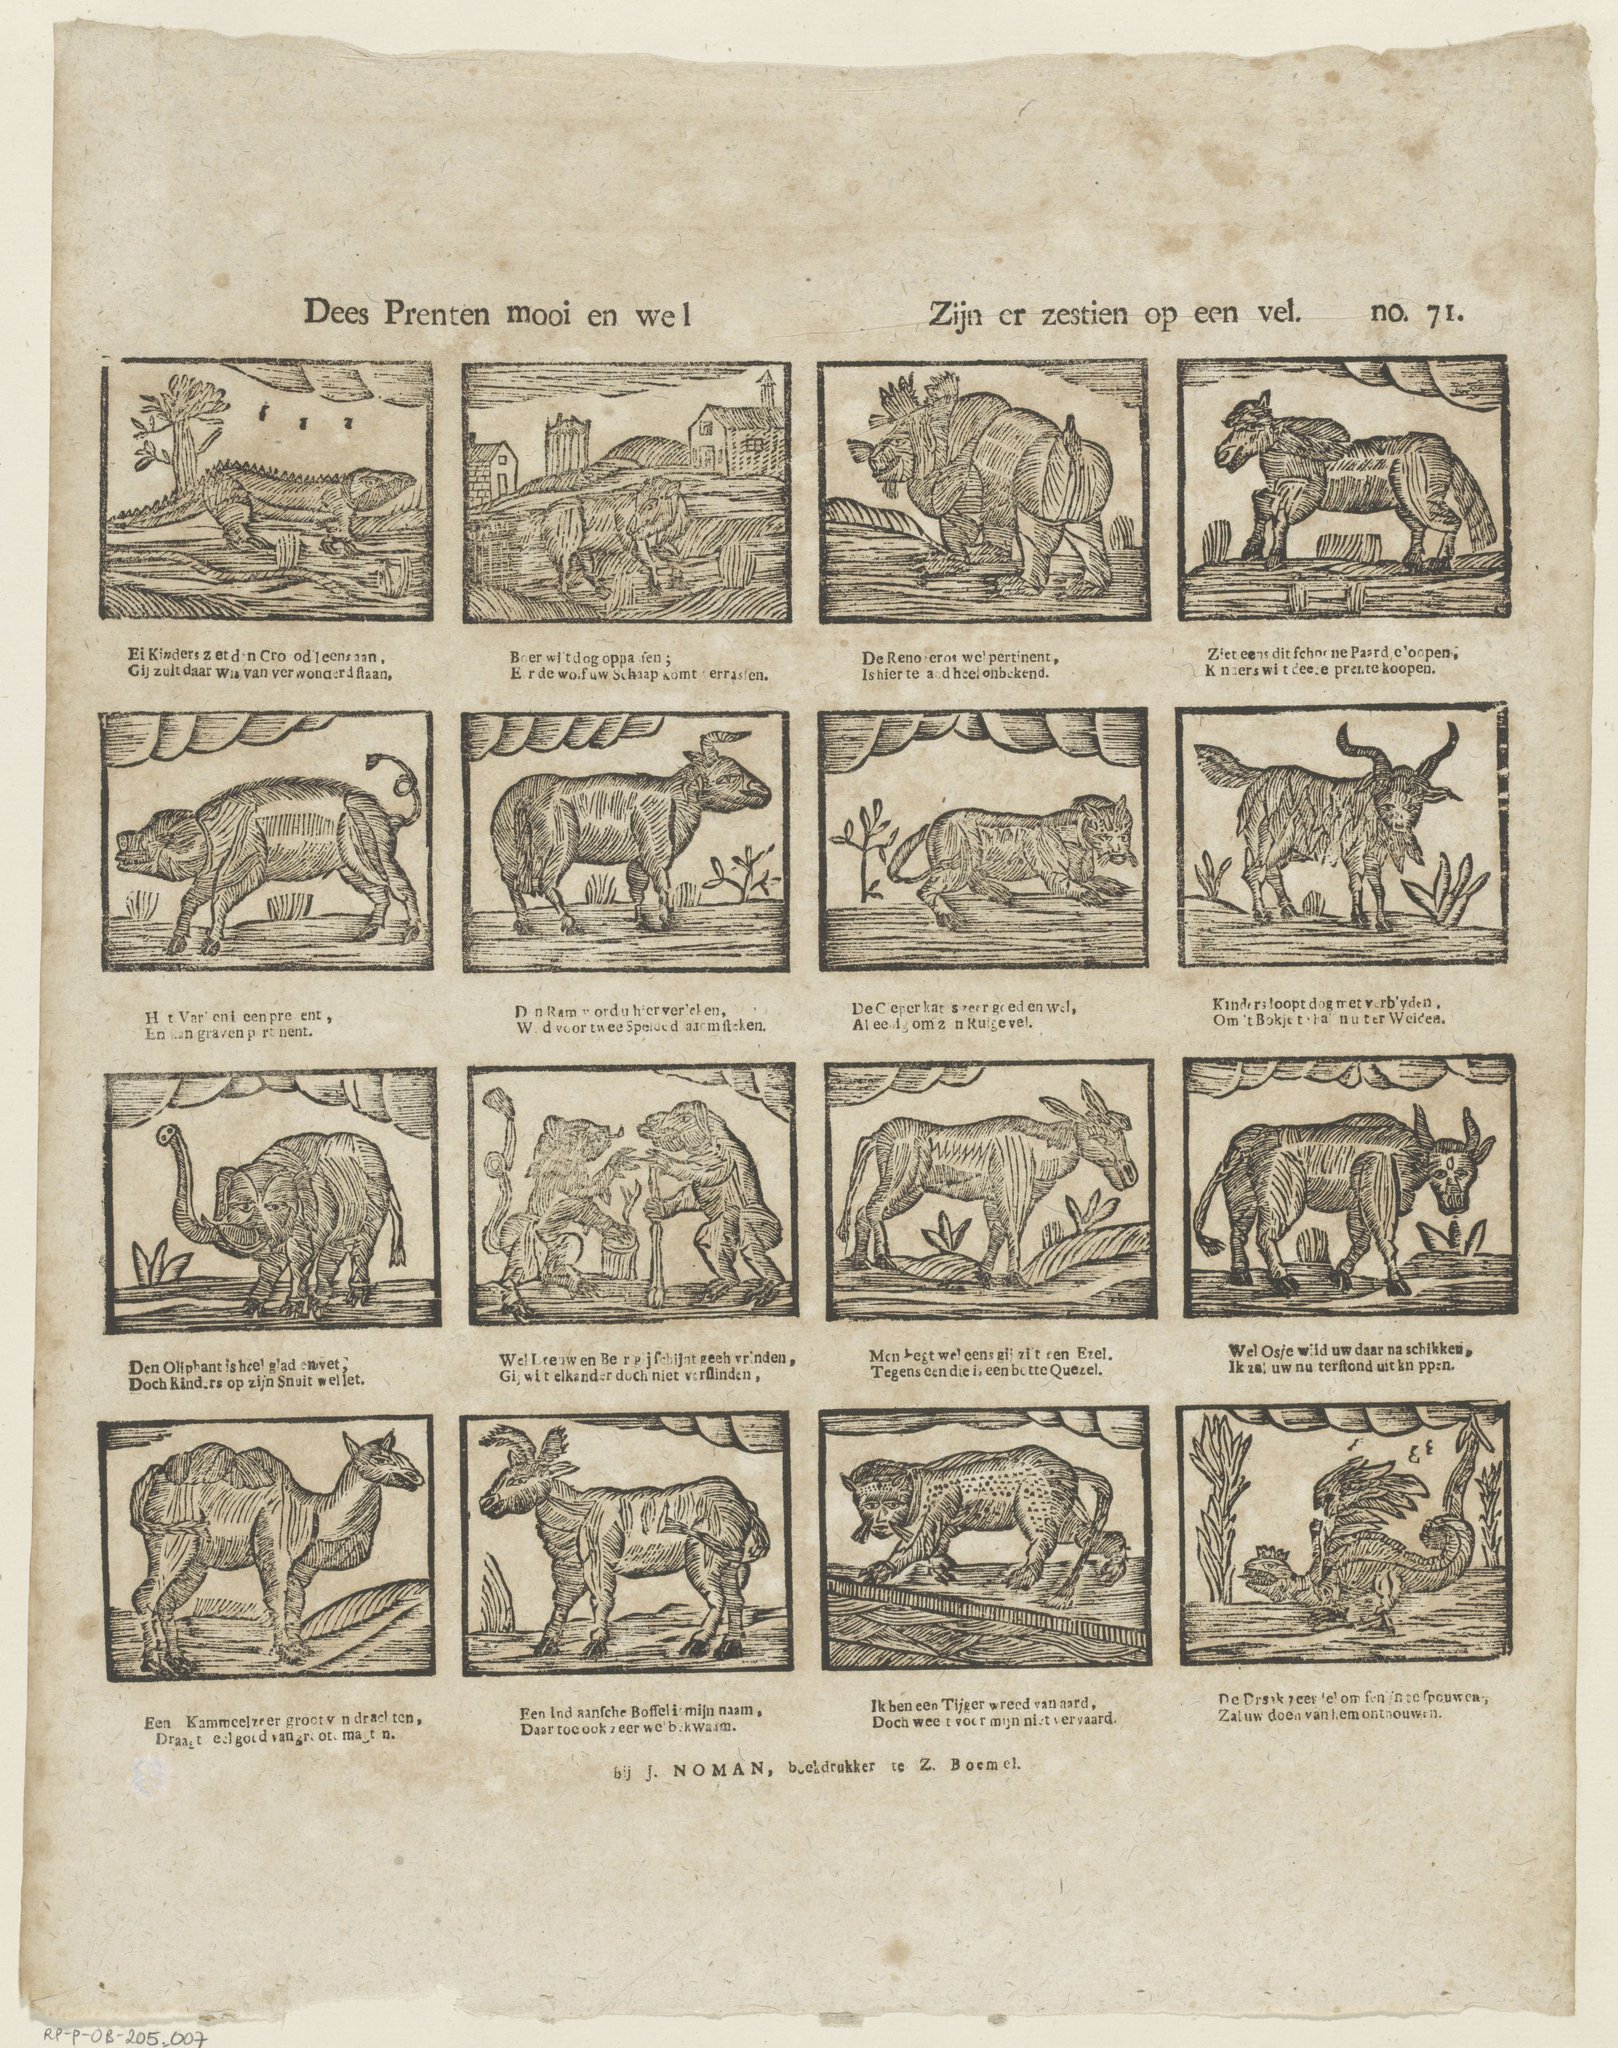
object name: print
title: Dees prent mooi en wel / Zijn er zestien op een vel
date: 1806-1830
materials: paper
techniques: letterpress printing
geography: netherlands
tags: hoofed animals: camel, animals, monkeys, apes, beasts of prey, predatory animals: bear, horse, beasts of prey, predatory animals: lion, trunked animals: elephant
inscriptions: collector's mark: Lugt 2760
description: Blad met 16 voorstellingen van dieren, zoals een krokodil, een paard, een bok en een olifant. Onder elke afbeelding een tweeregelig vers. Genummerd rechtsboven: no. 71.